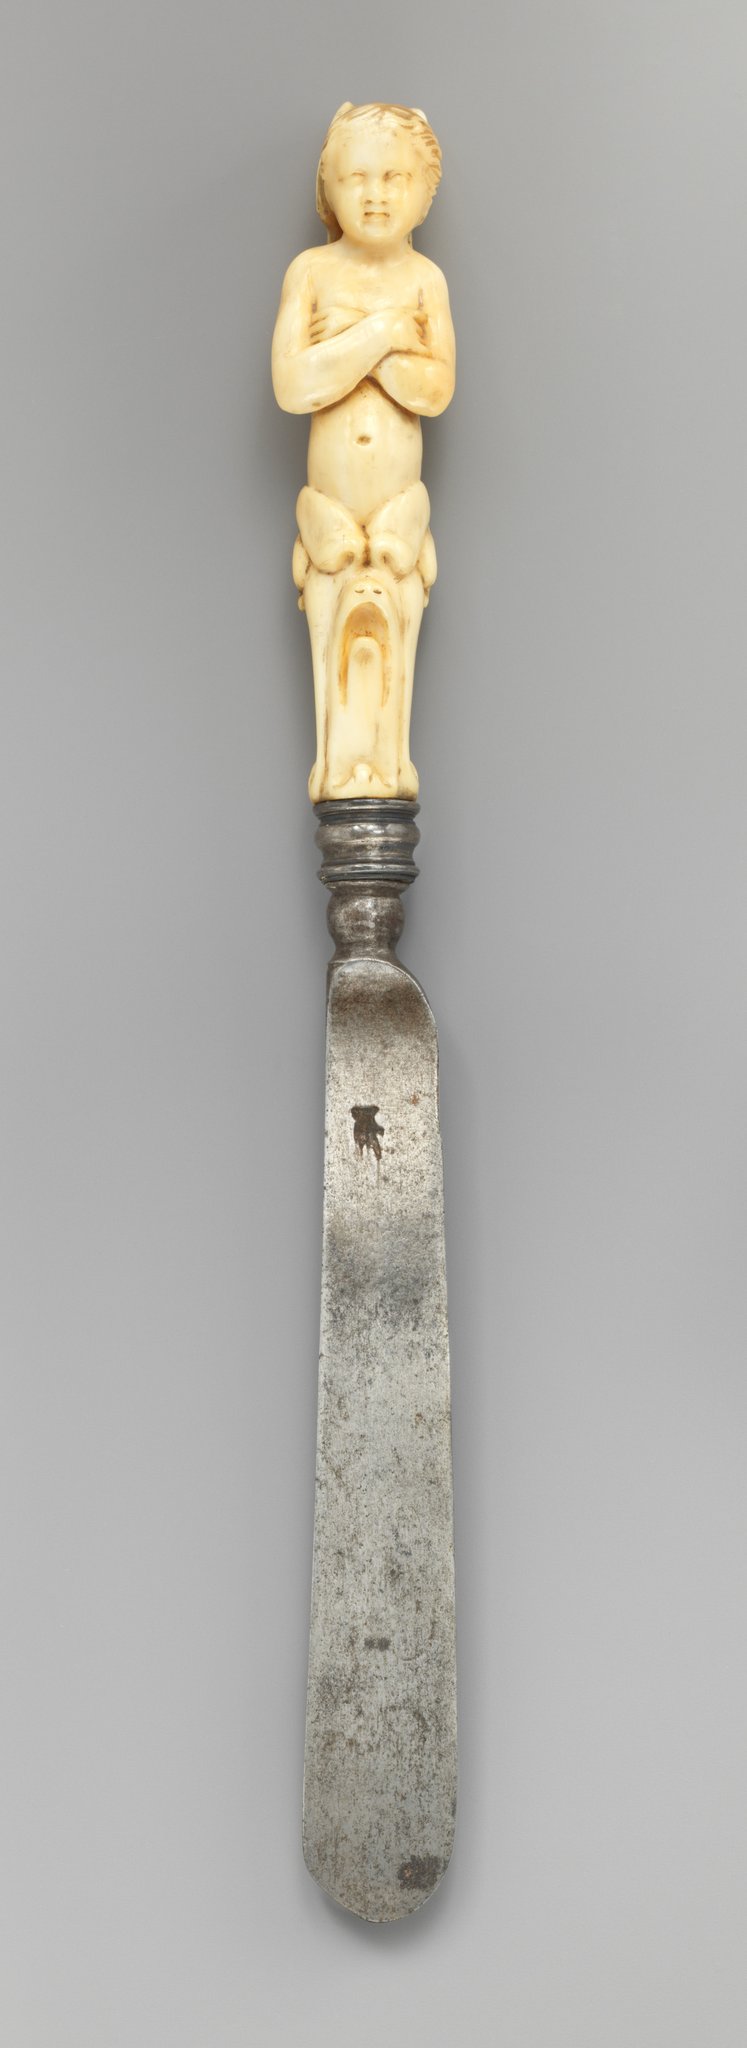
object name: knife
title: Knife with winged putto handle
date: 1601-1700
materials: ivory, steel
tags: putti